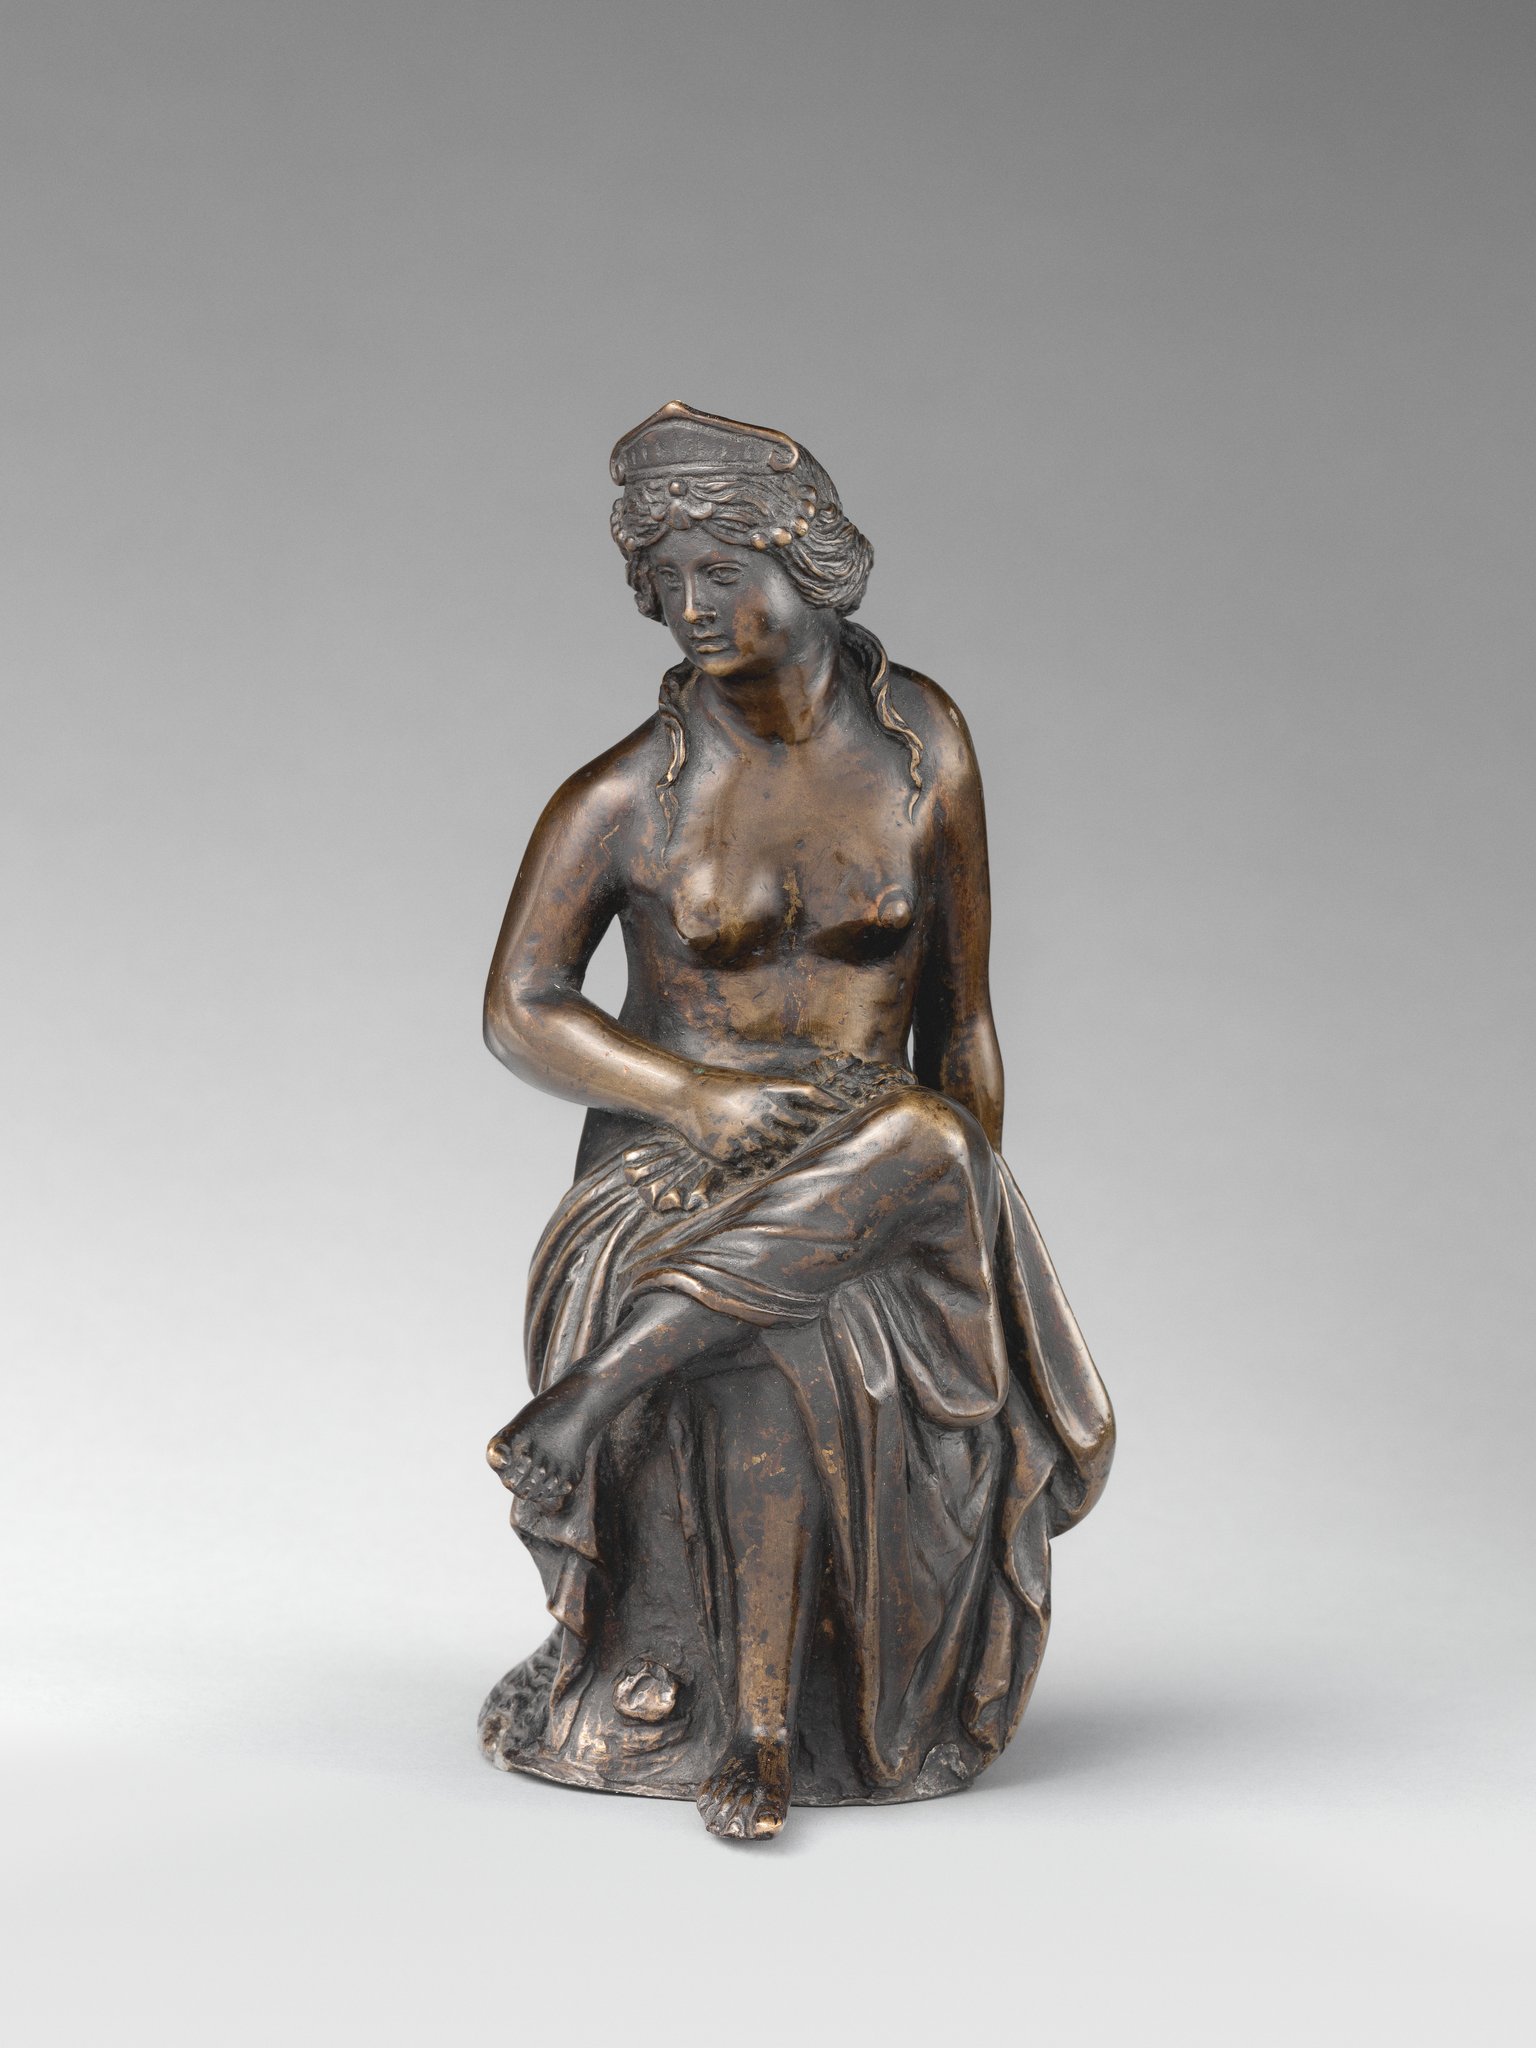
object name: statuette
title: Seated goddess holding flowers (Flora?)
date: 1550-1575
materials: bronze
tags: female nudes